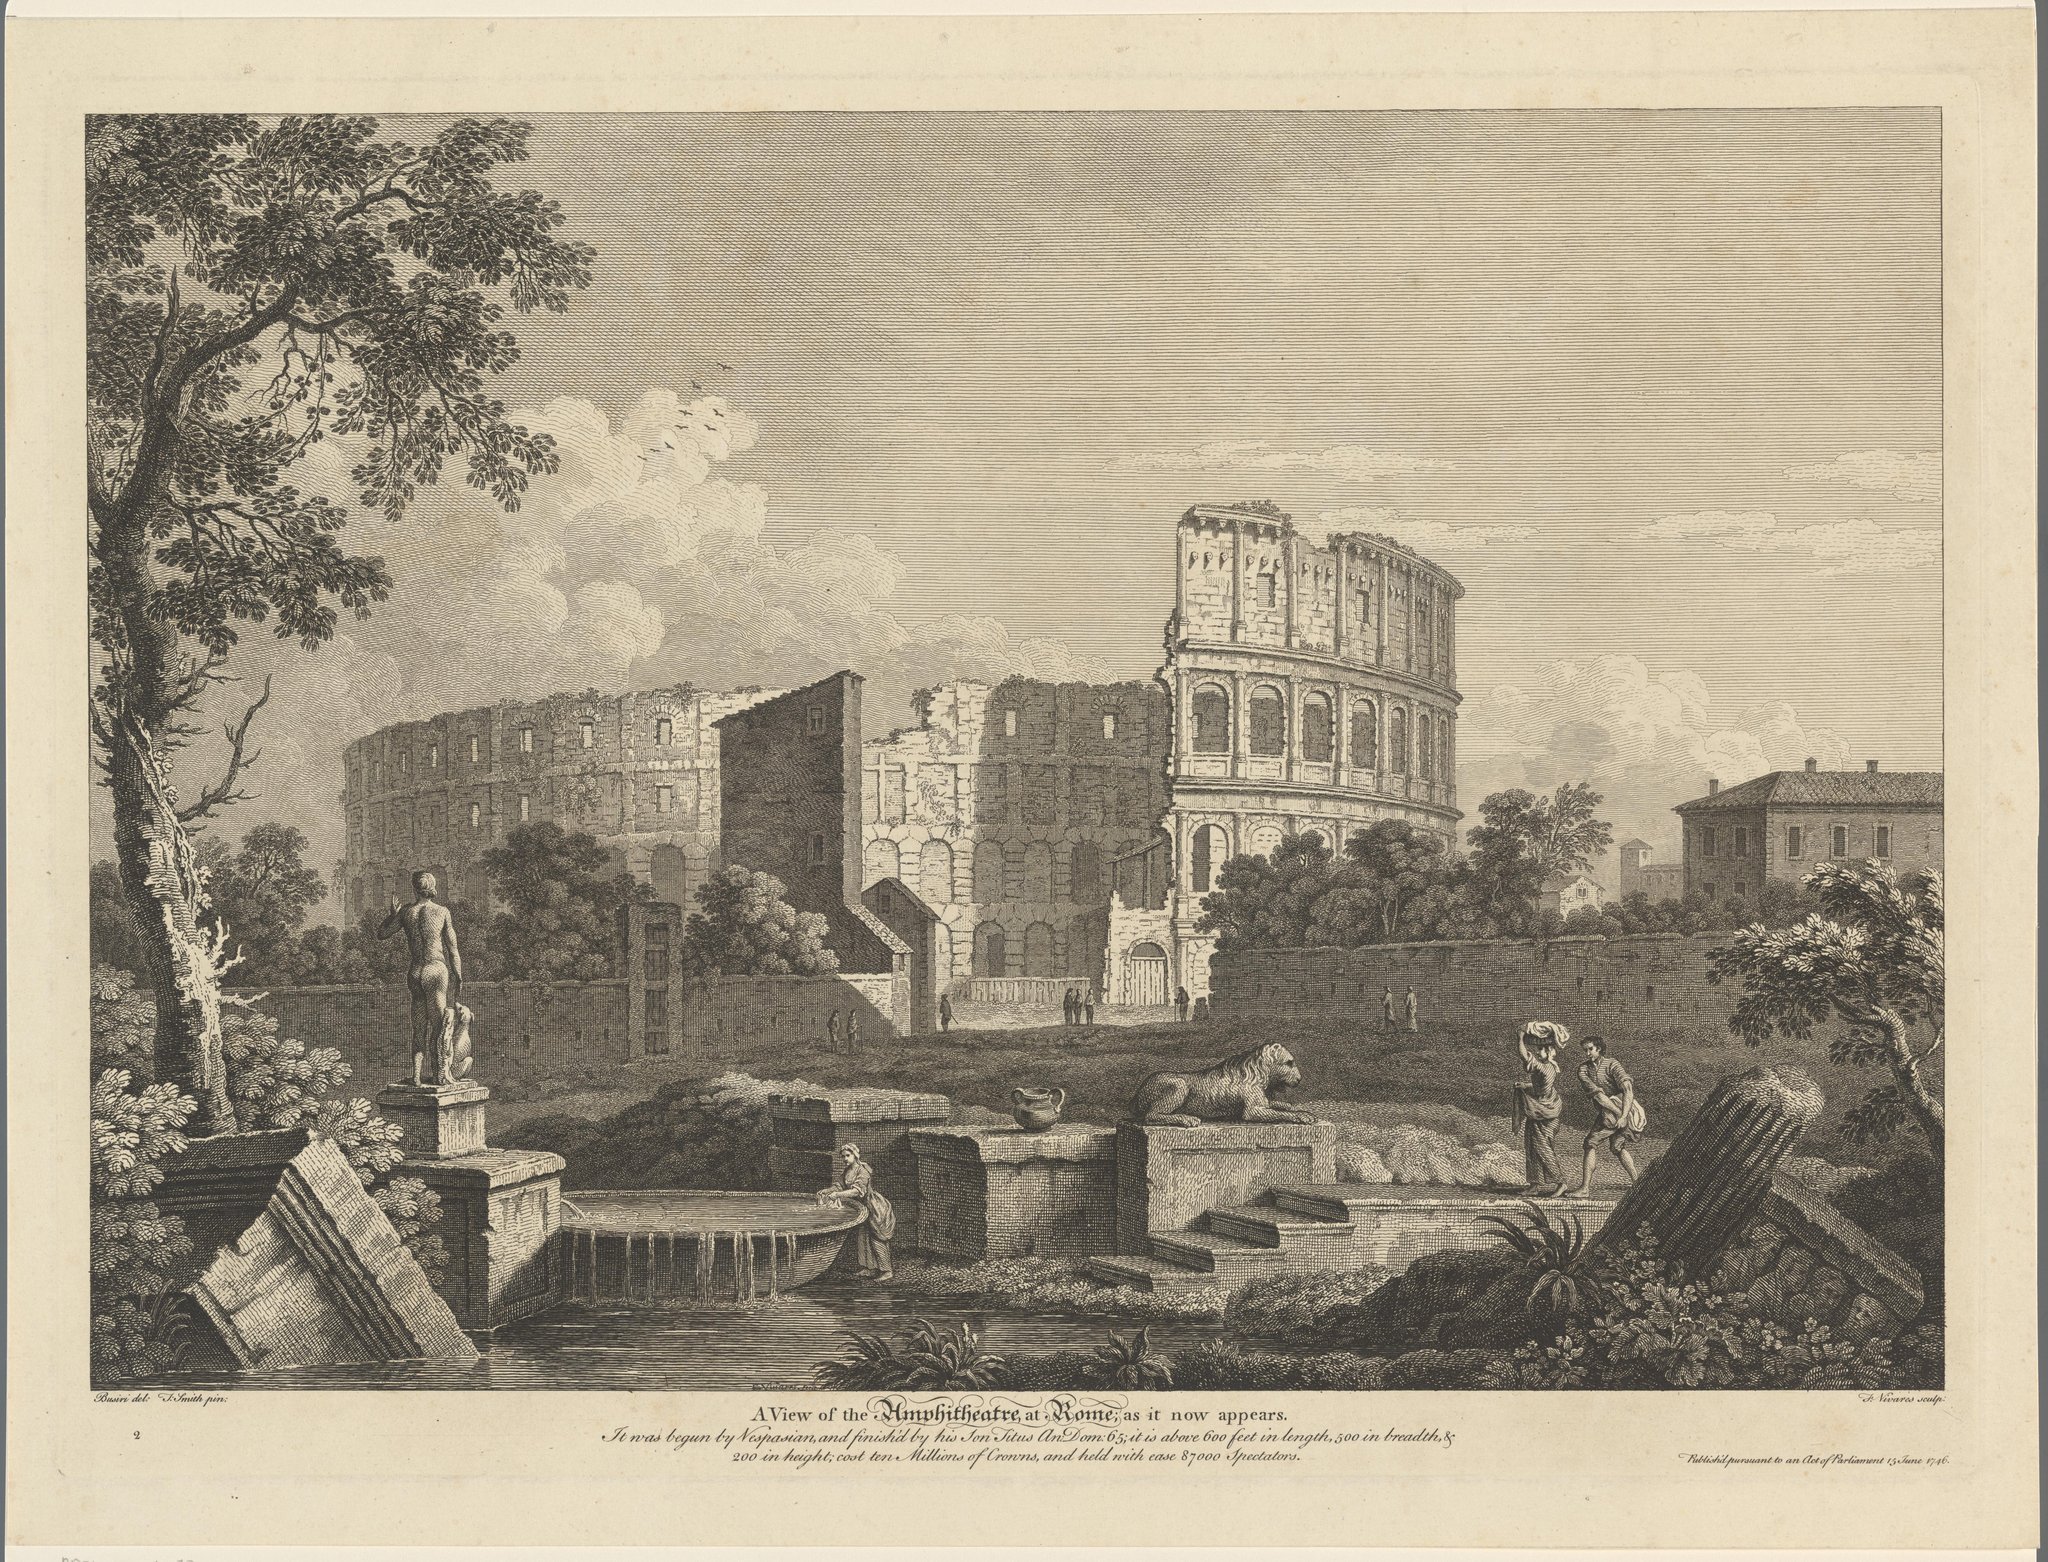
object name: print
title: Gezicht op het Colosseum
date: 1746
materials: paper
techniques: engraving, etching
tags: amphitheatre, laundering, landscape with ruins (+ city(-scape) with figures, staffage)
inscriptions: collector's mark: Lugt 2228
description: Tekst in het Engels in de ondermarge. Genummerd: 2.